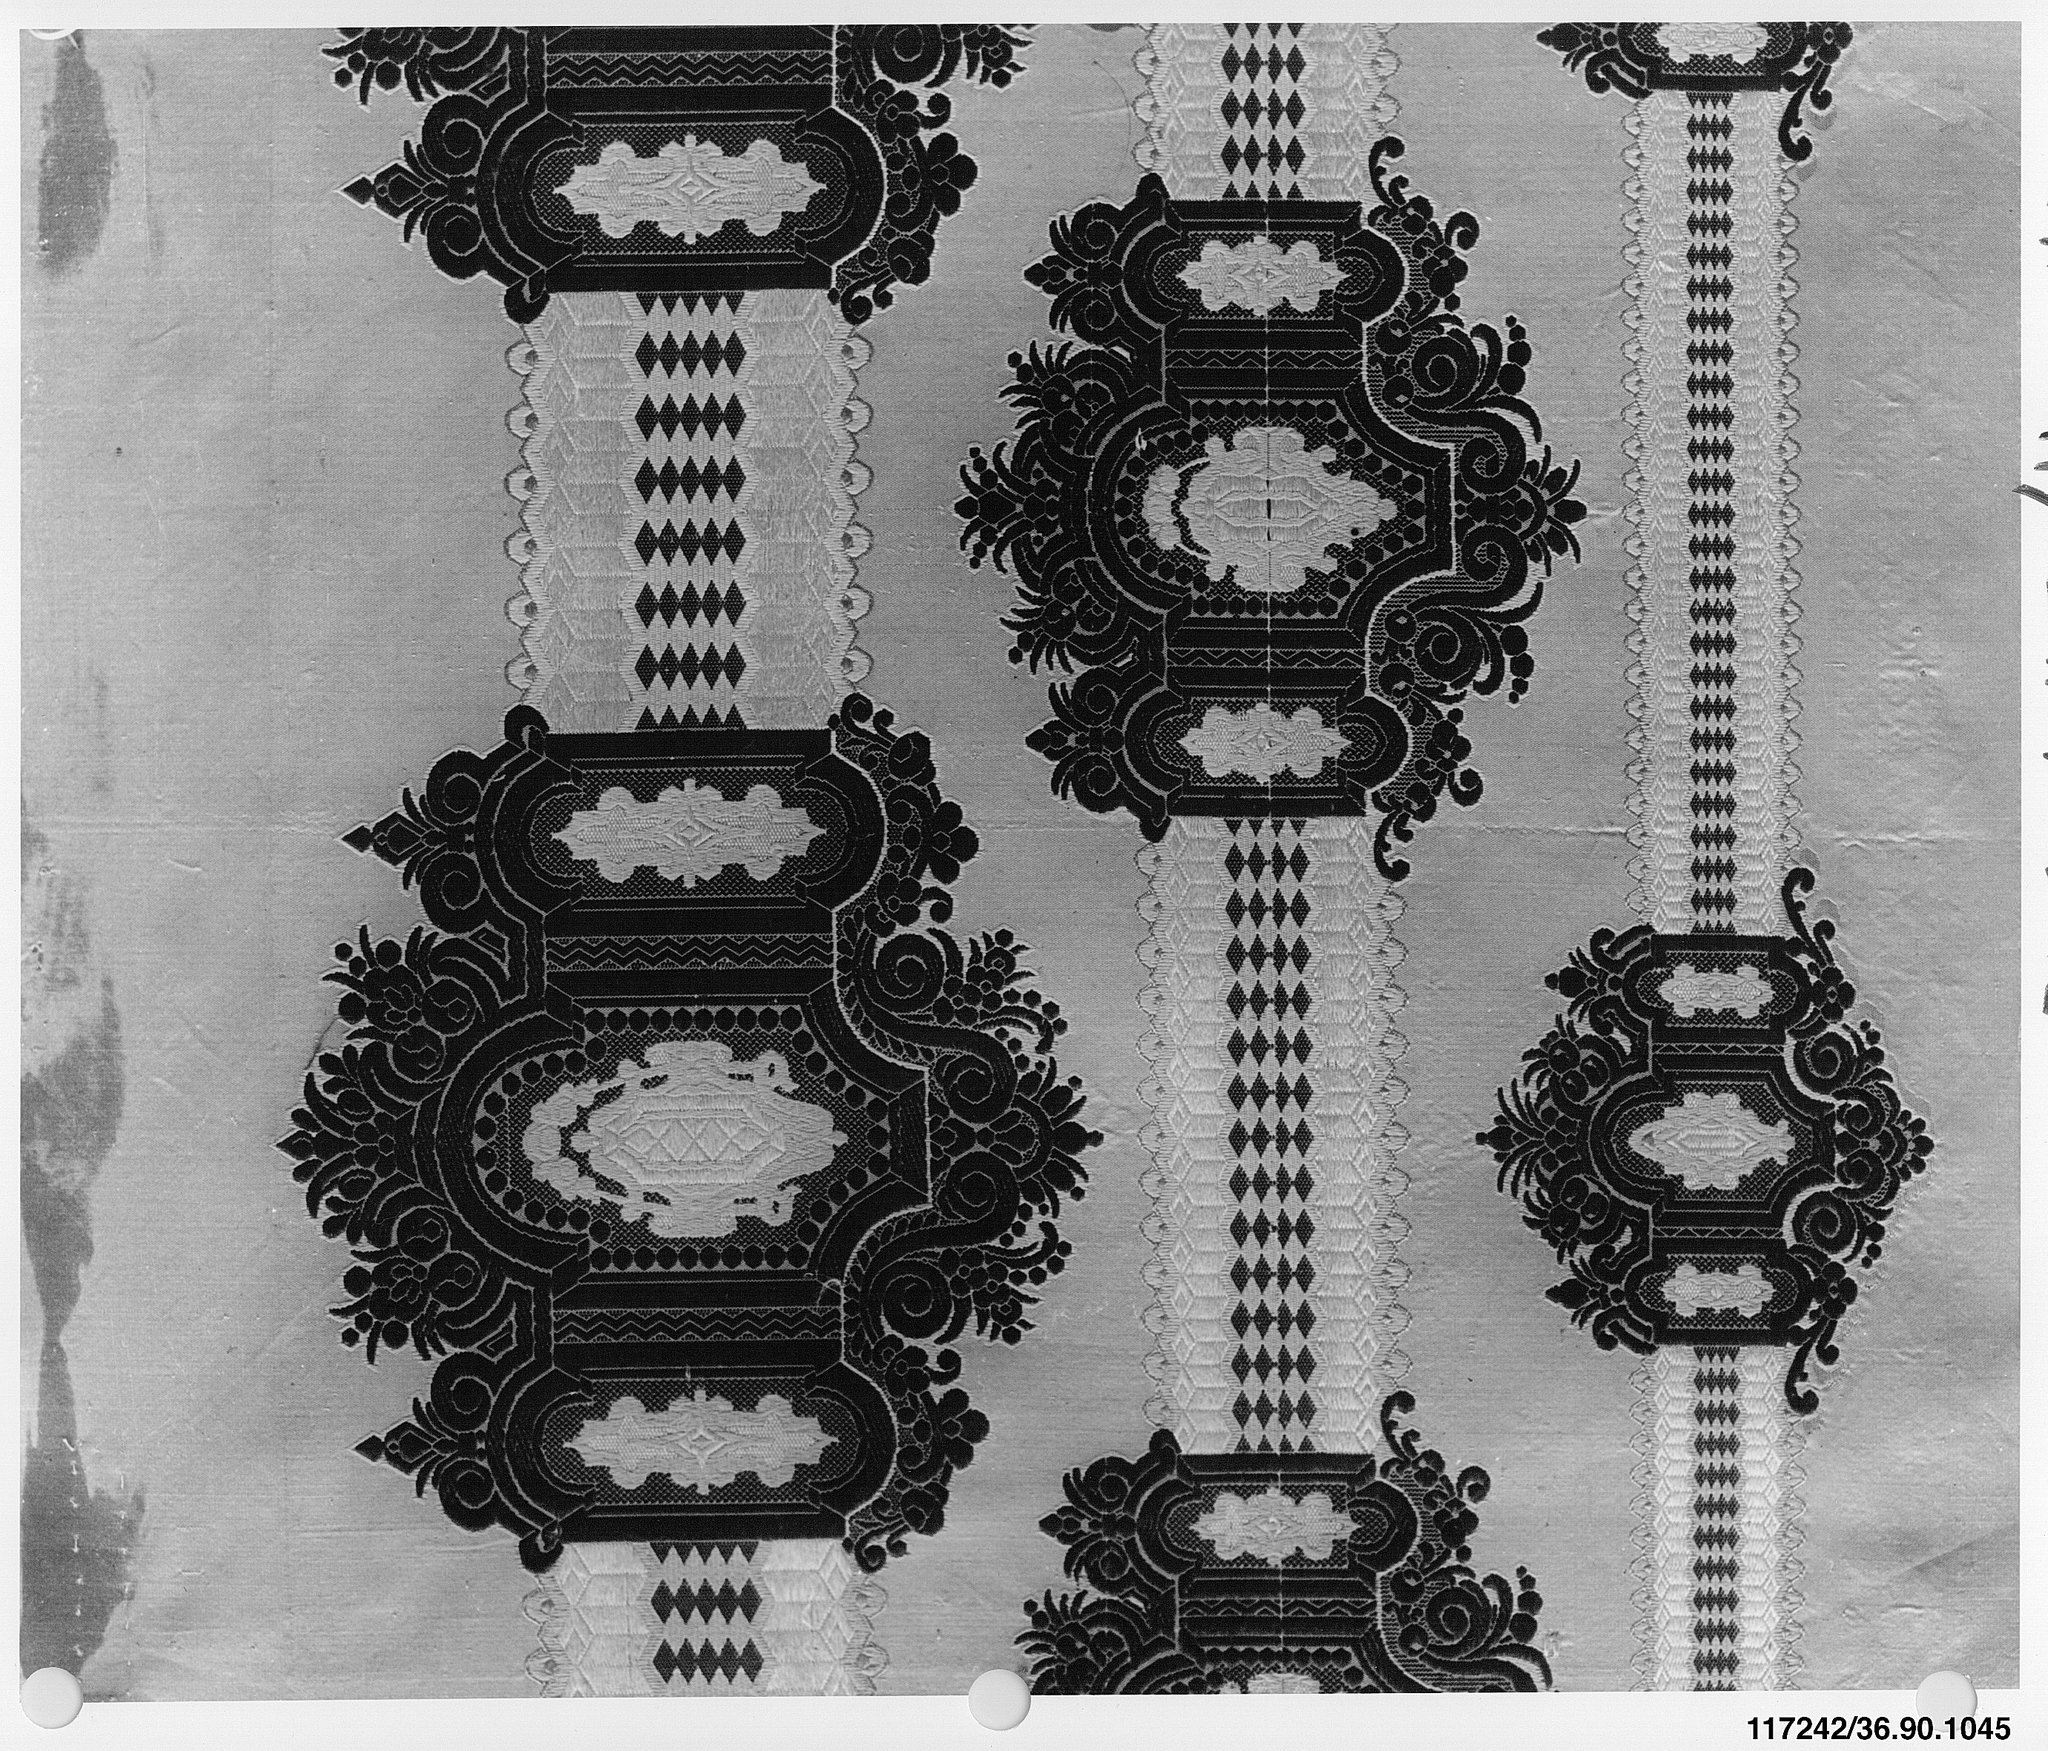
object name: piece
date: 1801-1900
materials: silk